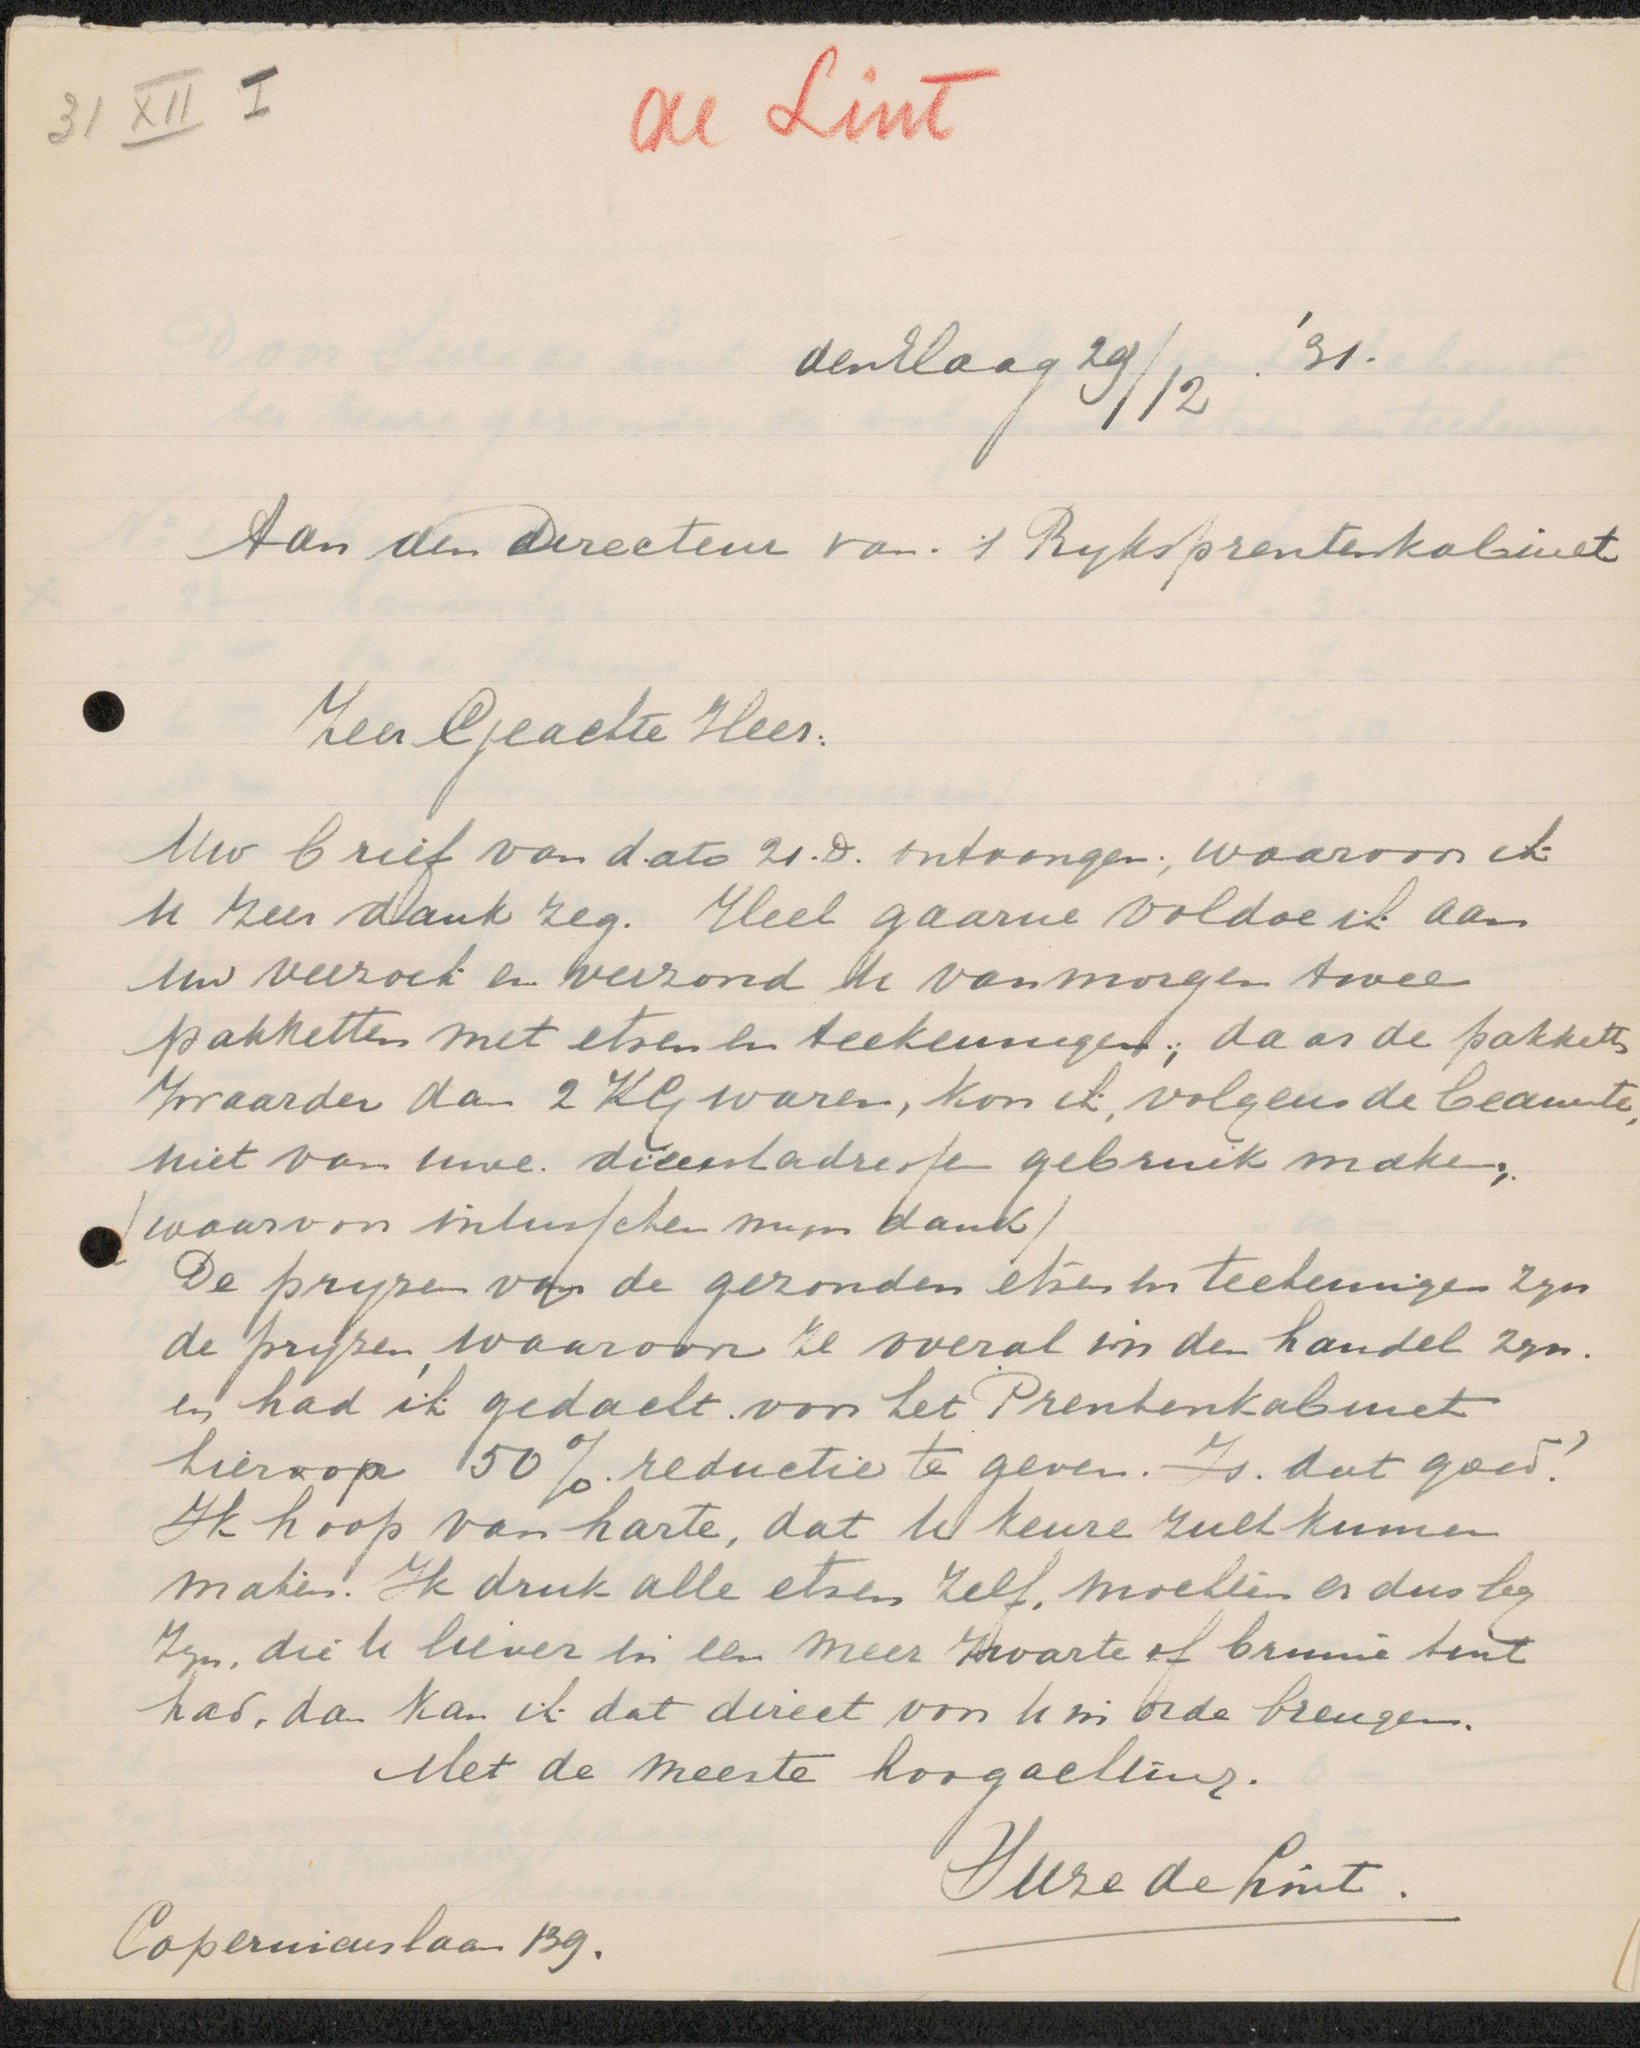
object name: letter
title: Brief aan jonkheer Hendrik Teding van Berkhout (1879-1969)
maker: suze de lint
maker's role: print maker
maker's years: 1878-1953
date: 1931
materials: ink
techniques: pen, writing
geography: the hague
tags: print room, haarlem, amsterdam, jonkheer hendrik teding van berkhout (1879-1969), drawing, the graphic arts, art collecting, money